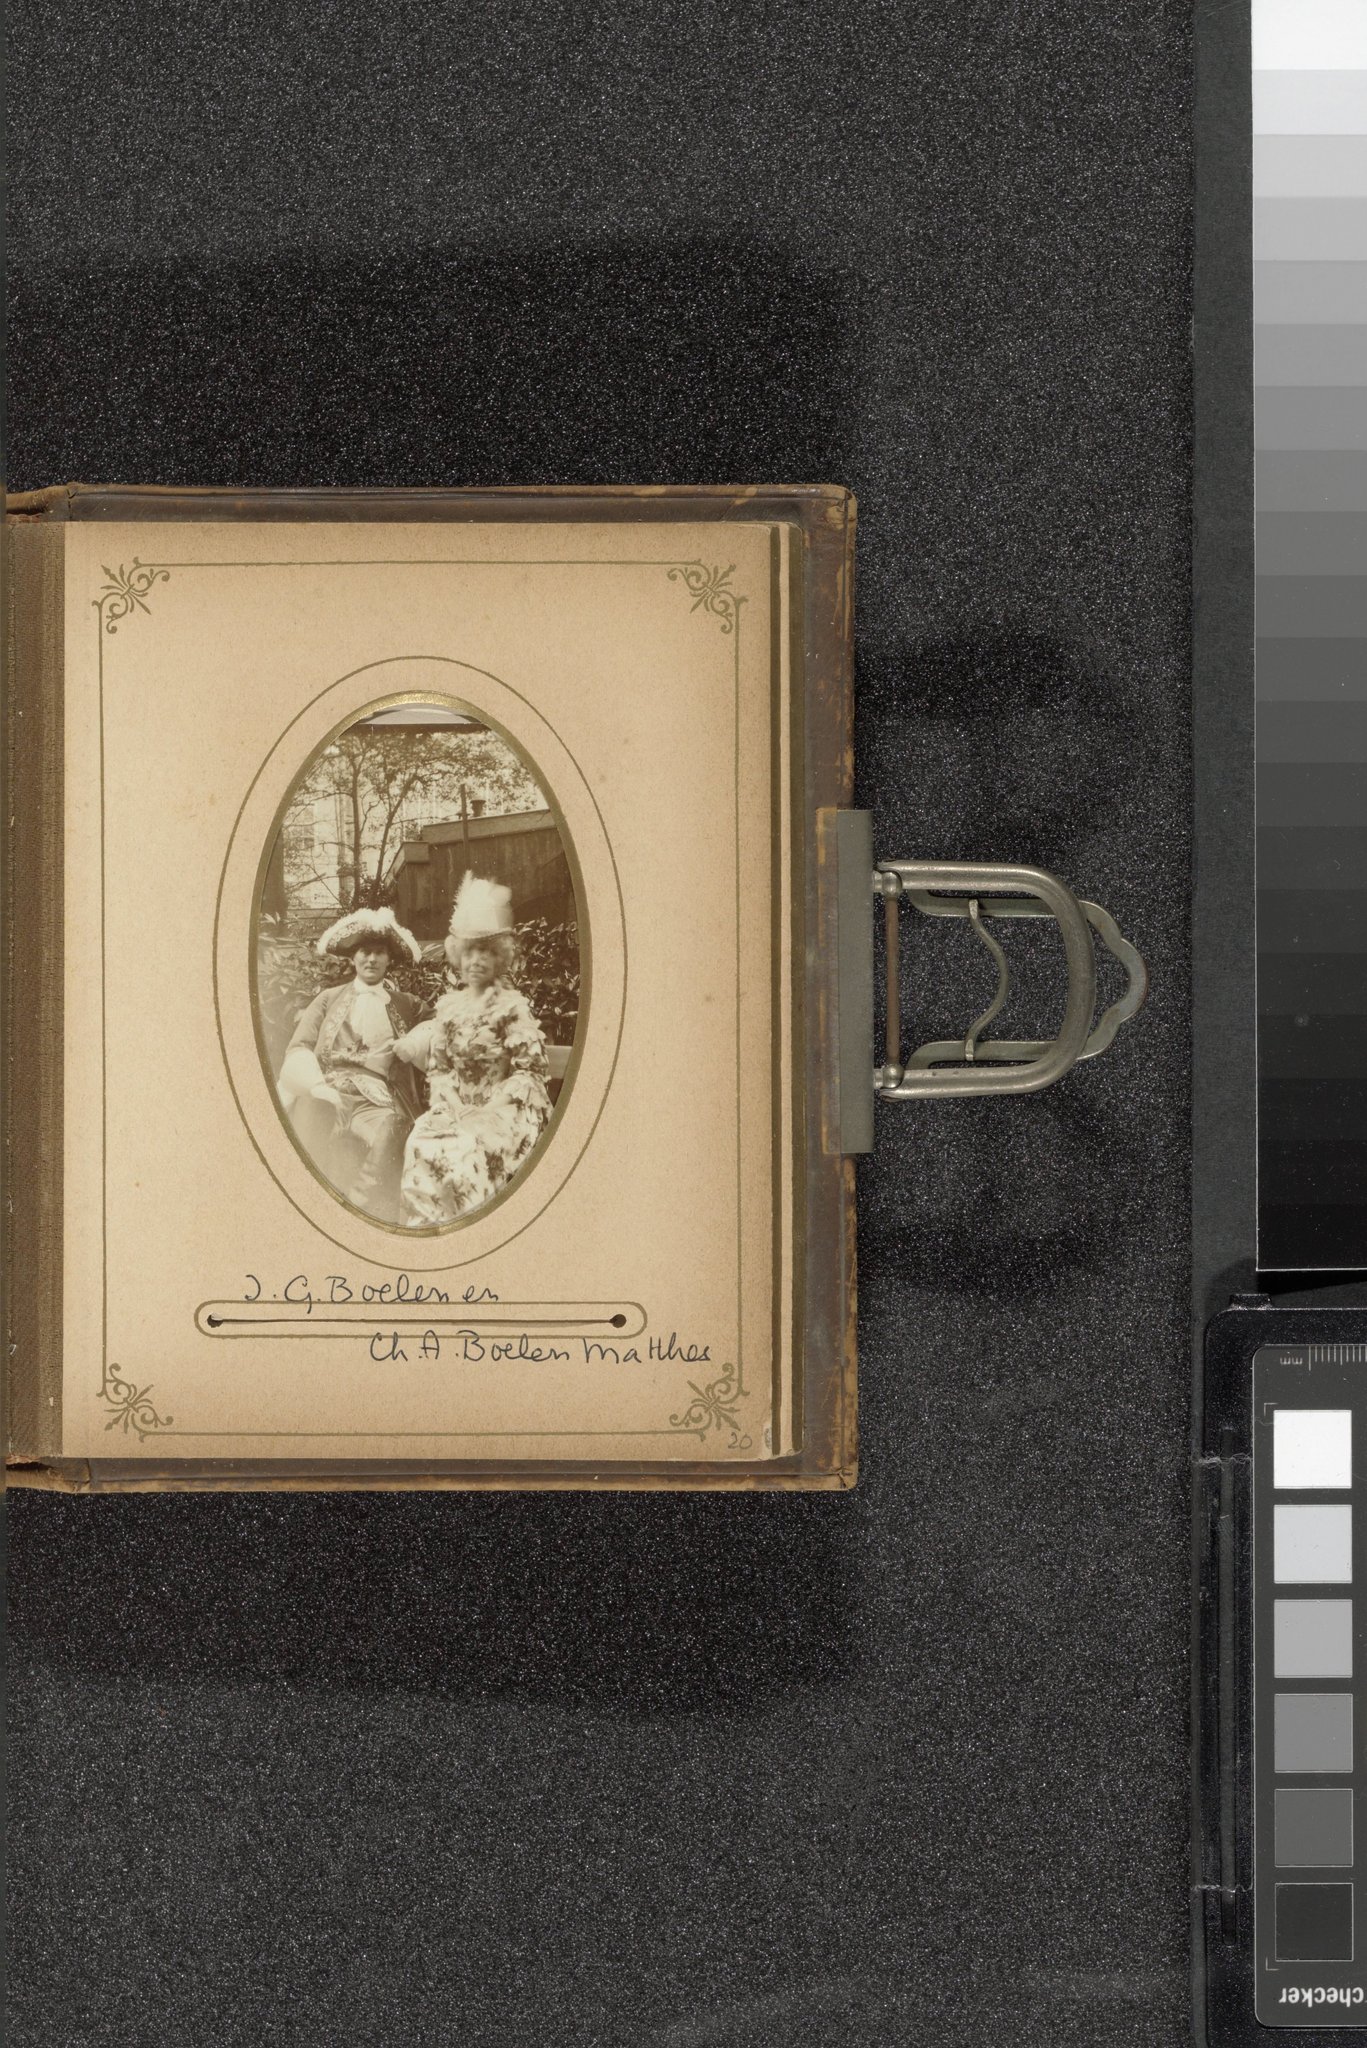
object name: photograph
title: Portret van J.G. Boelen en Ch. A. Boelen-Matthes, beiden verkleed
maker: Anonymous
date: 1865-1892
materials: cardboard, paper, photographic support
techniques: gelatin silver print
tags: charlotte alida boelen-matthes (lot), joan gerard boelen, dress-up party, historical persons - bb - woman, historical persons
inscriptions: name: ‘J.G. Boelen en Ch.A. Boelen-Matthes’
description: Onderdeel van Fotoalbum van de families Boelen, Matthes en Pennink.